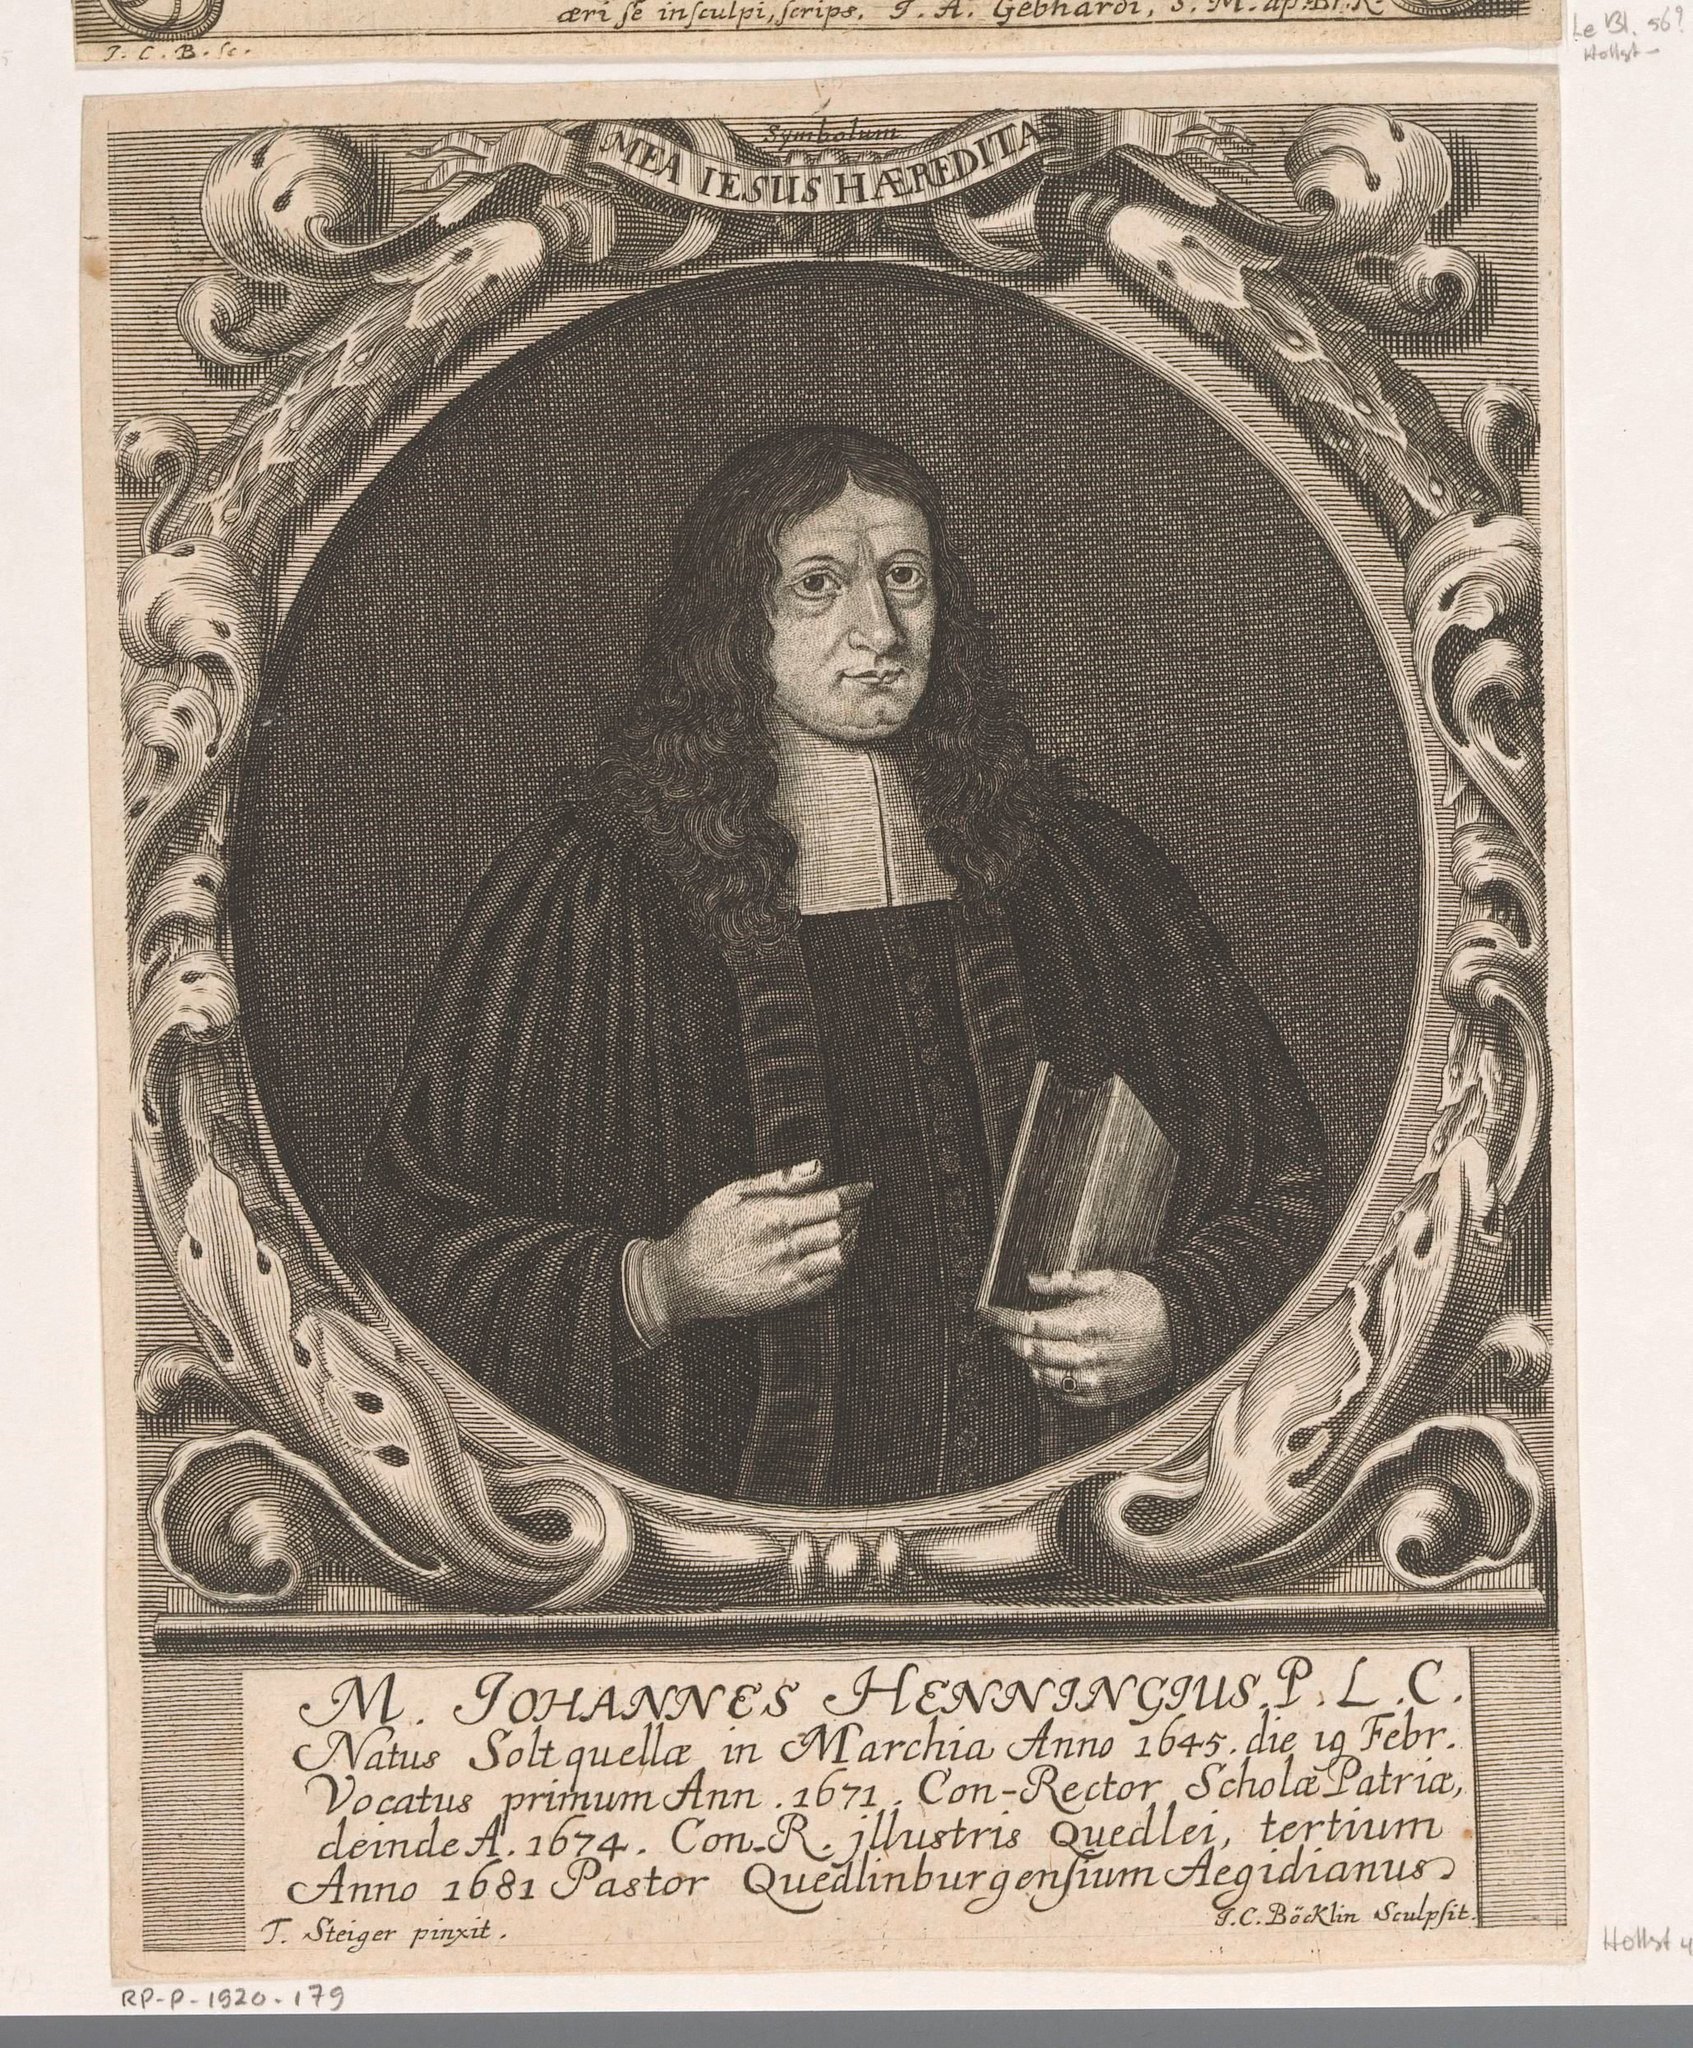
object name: print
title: Portret van Johannes Henning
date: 1681-1709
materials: paper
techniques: engraving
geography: leipzig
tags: historical persons, book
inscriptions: collector's mark: Lugt 2228